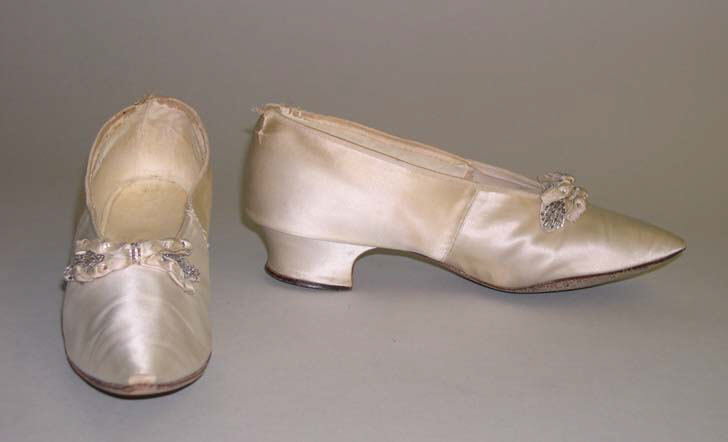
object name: evening shoe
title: Evening shoes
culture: american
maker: j. & j. slater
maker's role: manufacturer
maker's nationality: american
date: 1894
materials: glass, leather, silk